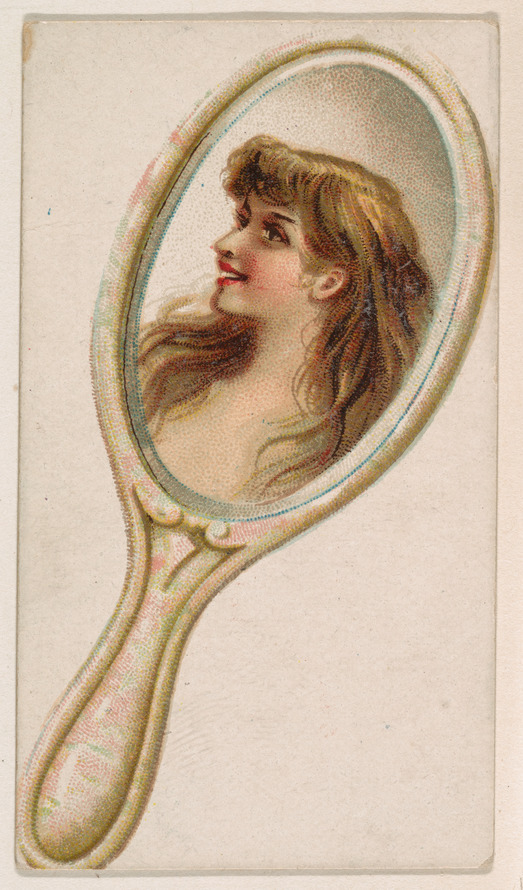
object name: print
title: Mirror, from the Novelties series (N228, Type 5) issued by Kinney Bros.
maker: kinney brothers tobacco company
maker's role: publisher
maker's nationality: american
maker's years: 1869-2011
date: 1889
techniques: color lithograph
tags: girls,mirrors